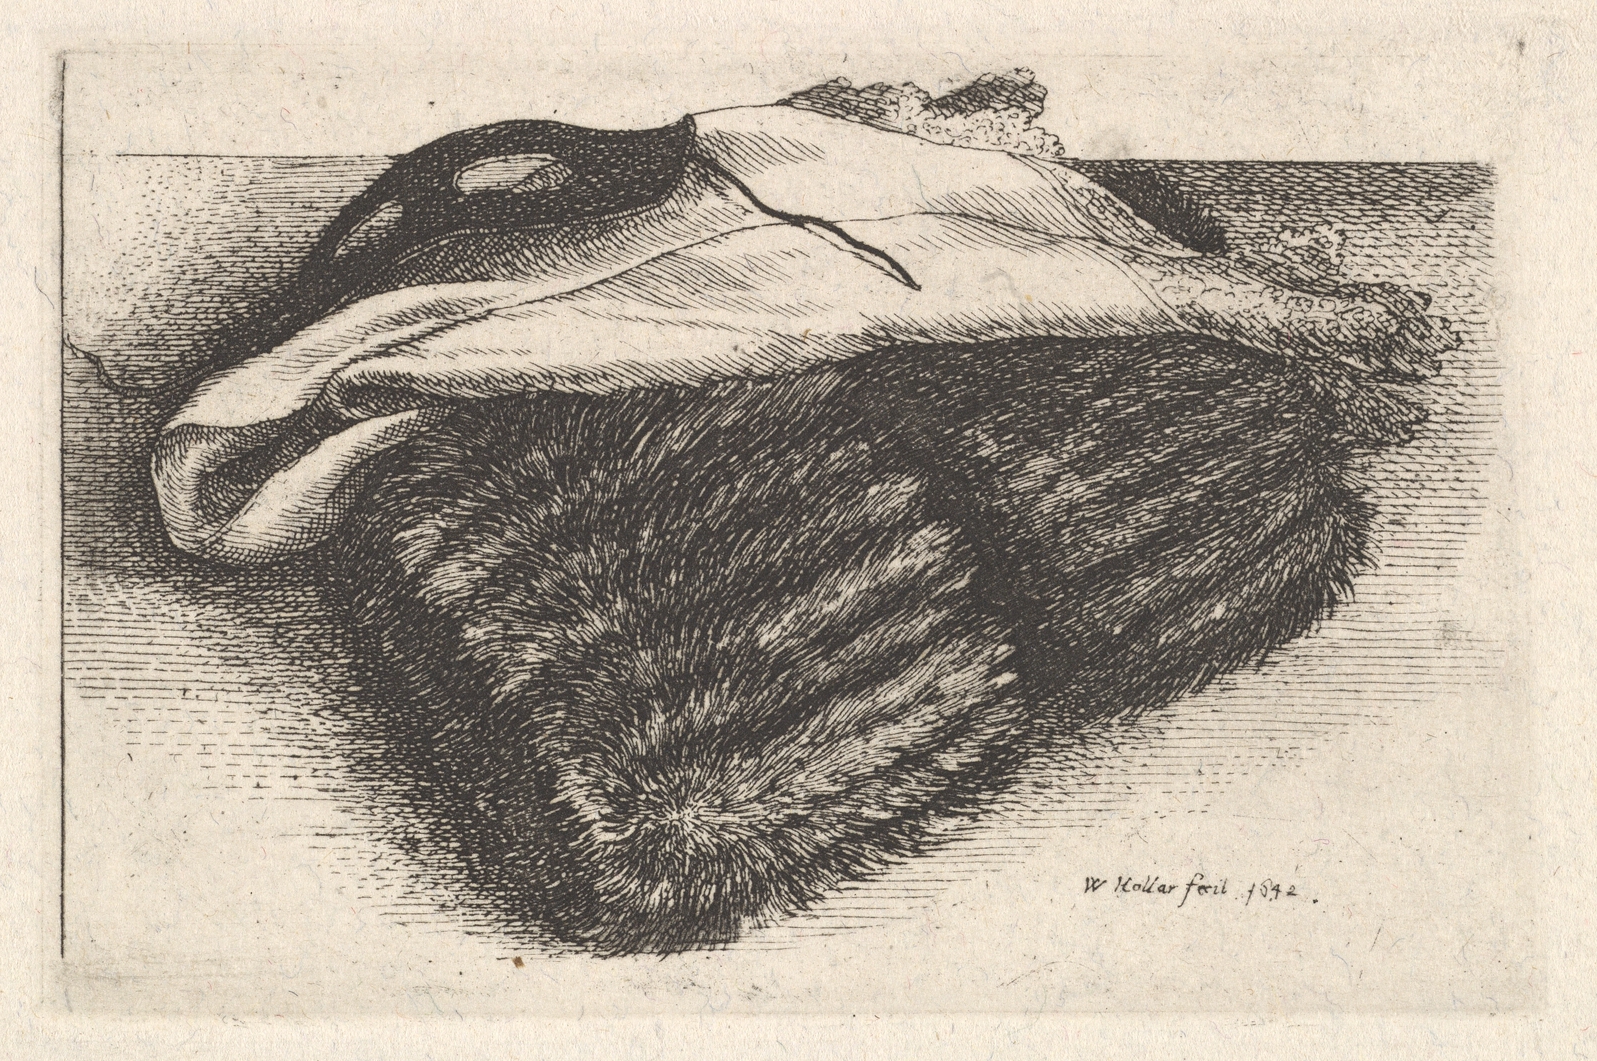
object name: print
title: Muff, white kerchief and mask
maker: wenceslaus hollar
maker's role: artist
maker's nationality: bohemian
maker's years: 1607-1677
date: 1901-2000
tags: masks